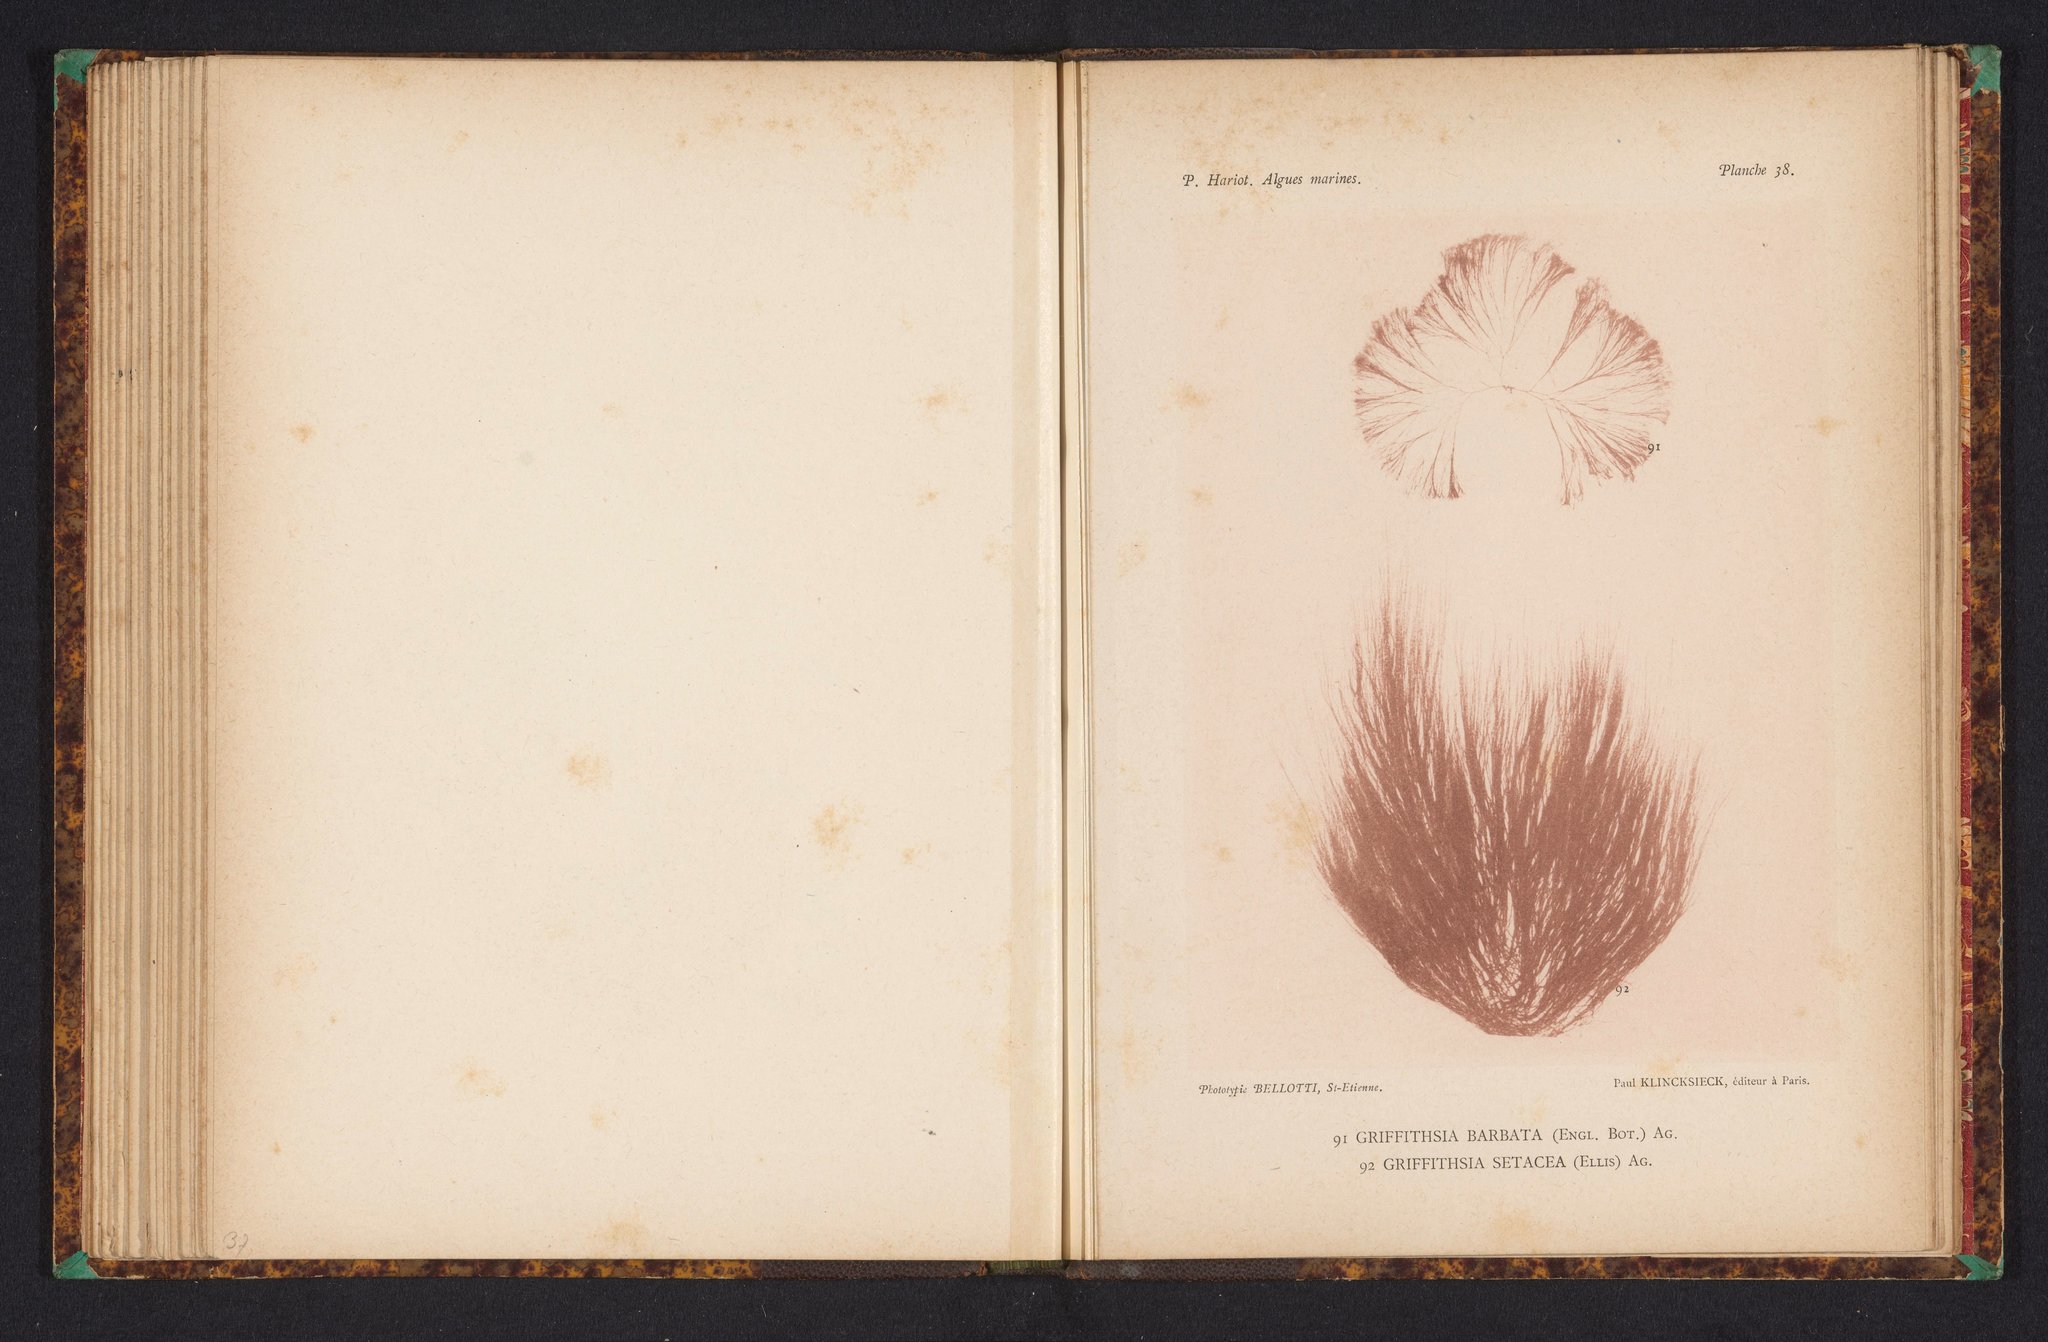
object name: photomechanical print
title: Twee soorten zeewier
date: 1882-1892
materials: paper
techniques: photograph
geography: france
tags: algae, seaweed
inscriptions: number: ‘91 (...) 92’, number: ‘Planche 38.’, inscription: ‘Griffithsia (...) setacea (Ellis) Ag.’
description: (91) is Griffithsia barbata, (92) is Griffithsia setacea.